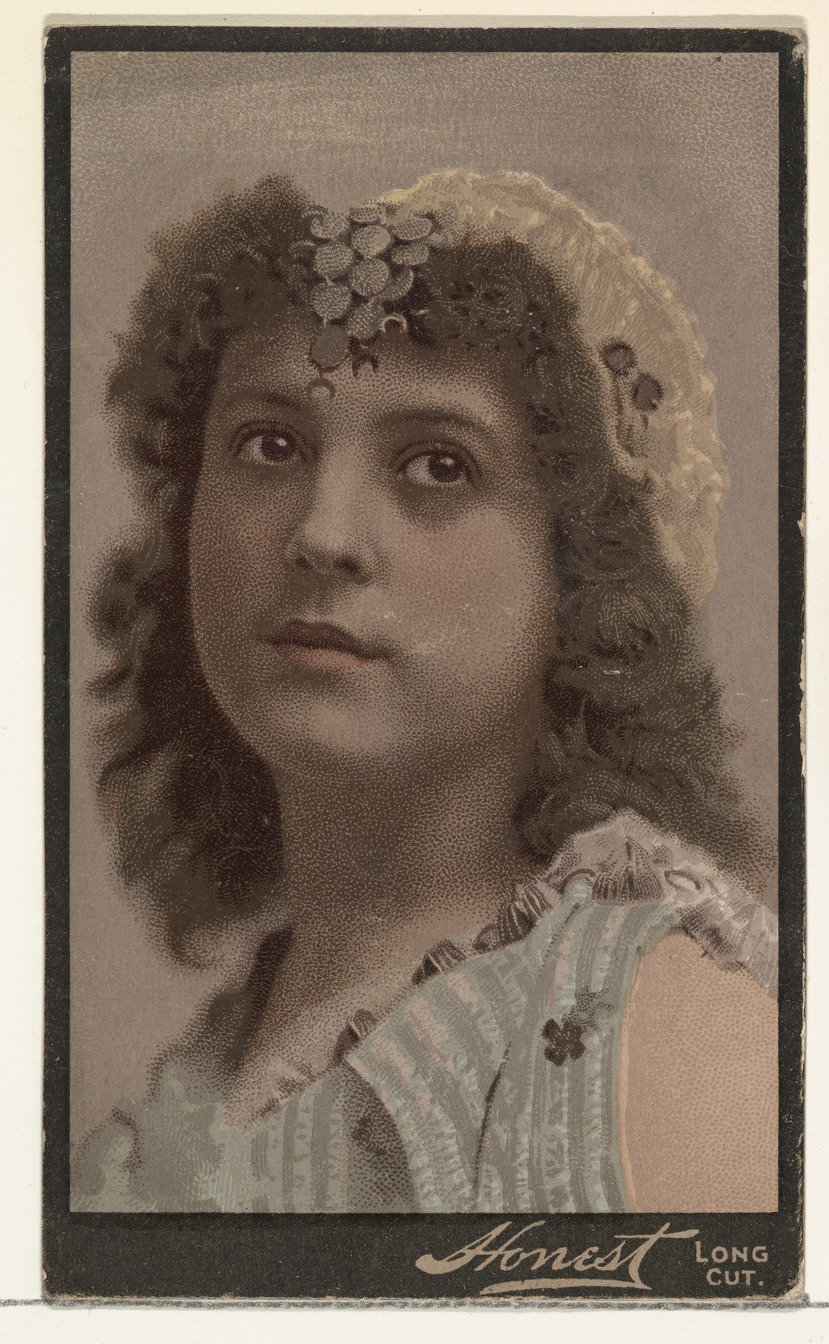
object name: print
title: Actress wearing cloth headpiece embellished with silver coins, from Stars of the Stage, Third Series (N131) issued by Duke Sons & Co. to promote Honest Long Cut Tobacco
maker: w. duke, sons & co.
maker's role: publisher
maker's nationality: american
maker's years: 1870-1920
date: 1891-1892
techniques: color lithograph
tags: portraits,women,actresses